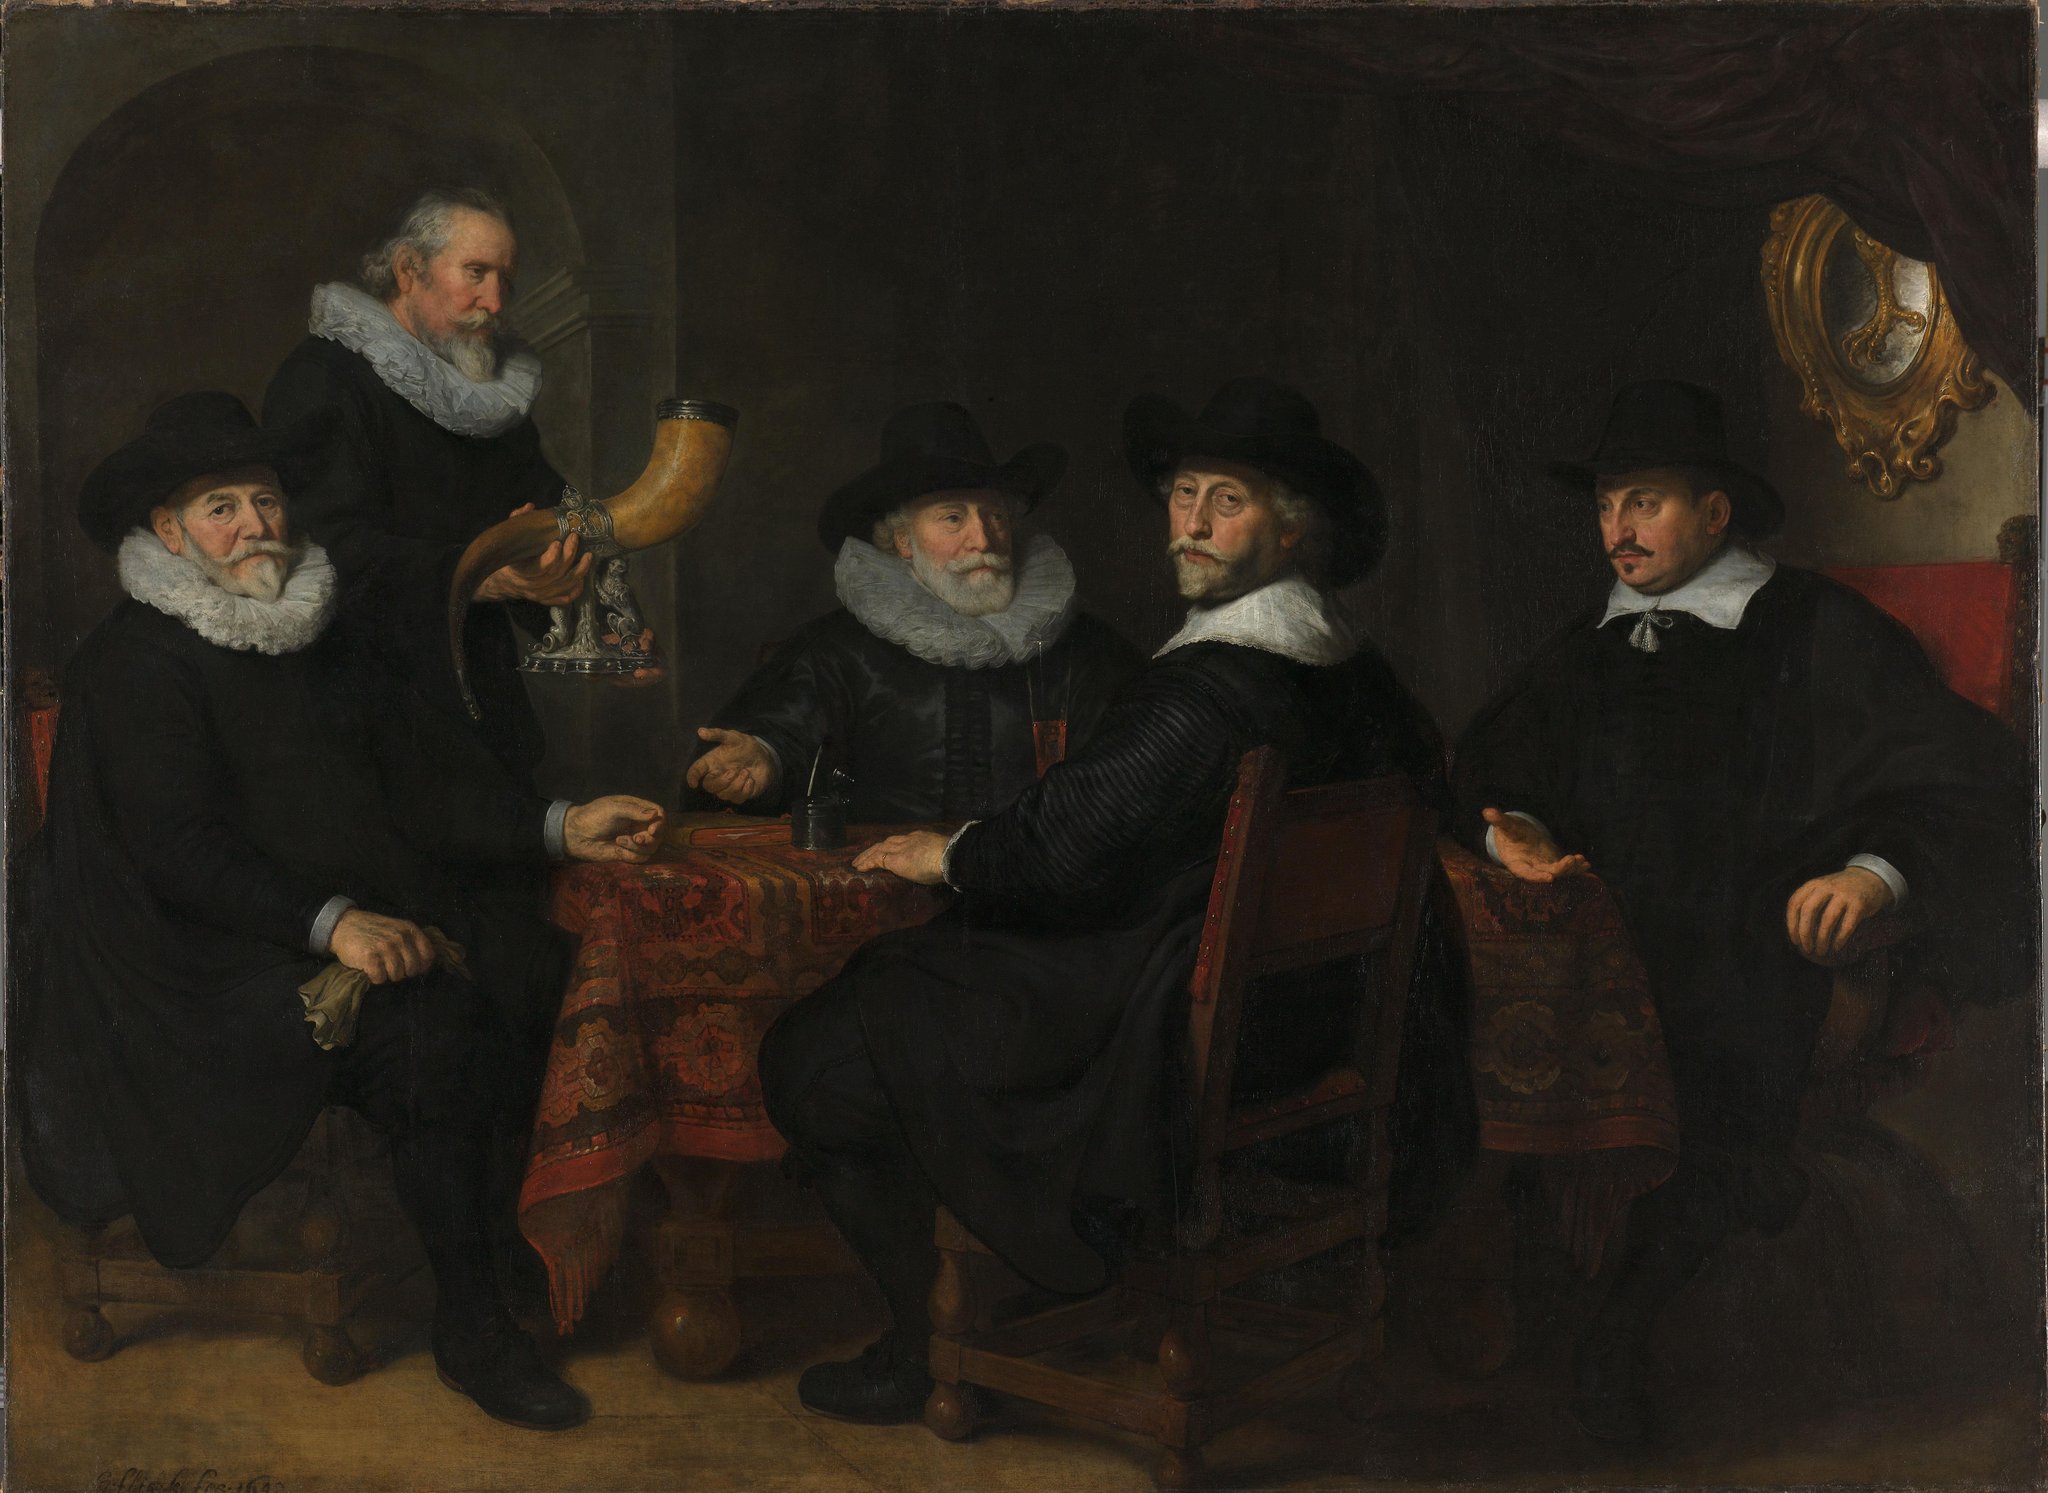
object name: painting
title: Portrait of the Governors of the Kloveniersdoelen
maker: govert flinck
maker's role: draughtsman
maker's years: 1615-1660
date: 1642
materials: canvas, oil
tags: amsterdam, board of a guild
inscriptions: signature and date, lower left: ‘G.flinck fec: 1642’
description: Groepsportret van de vier doelheren der Kloveniersdoelen, Amsterdam, 1642, zittend rond een tafel: Albert Coenraetsz Burgh, Jan Claesz Vlooswijck, Pieter Reael en Jacob Willekens. De kastelein Jacob Pietersz Nachtglas brengt hen de zilveren gildebeker, een hoorn van buffelhoorn (zie inv.nr. BK-AM-12). Rechts aan de wand het ingelijste embleem van de Kloveniers, de klauw.